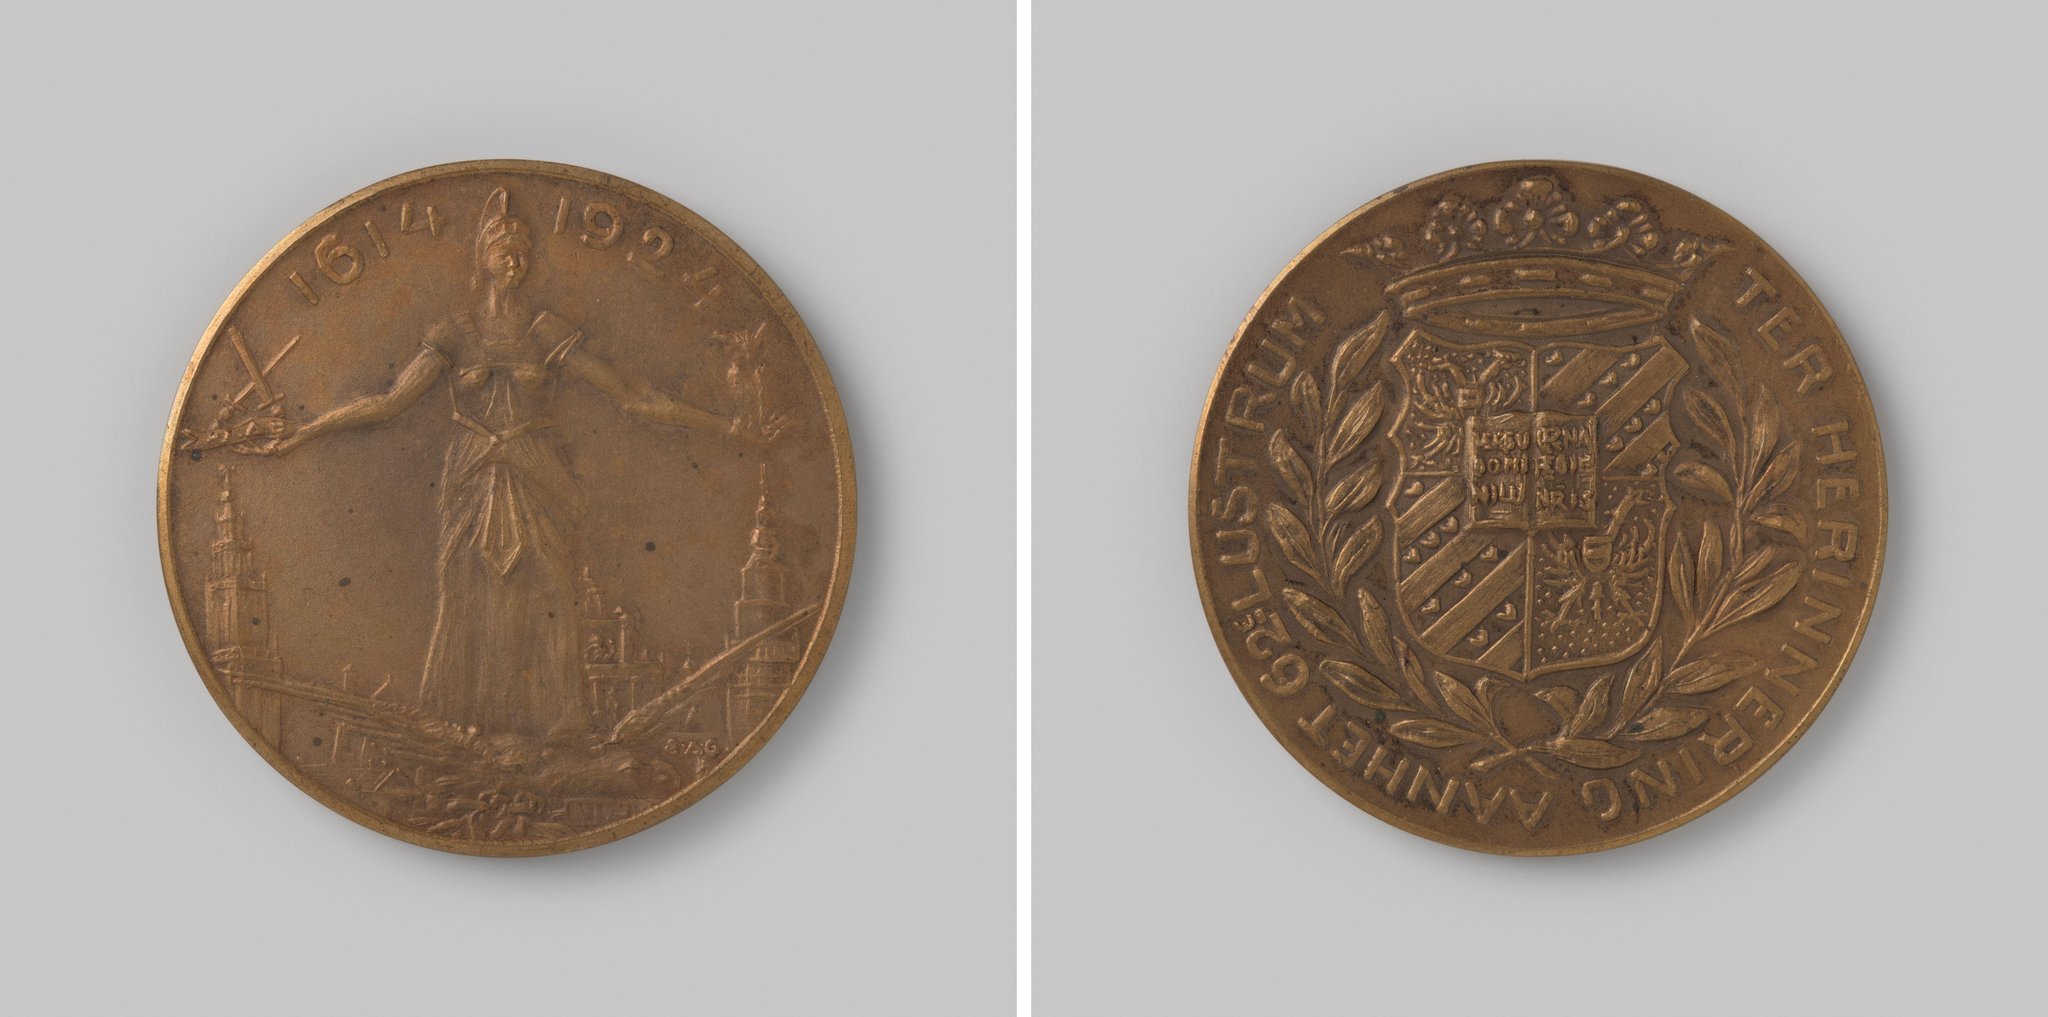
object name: history medal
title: 62ste lustrum (310-jarig bestaan) van de Universiteit van Groningen 1924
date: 1924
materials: bronze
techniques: striking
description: Bronzen penning, op de voorzijde een aanziende Minerva, in de uitgestrekte handen het universiteitsembleem en een uil, staand op een adelaar vliegend naar rechts over de stad Groningen, met bovenaan omschrift, op de keerzijde het gekroonde wapenschild van de stad Groningen tussen lauwertakken, met omschrift.